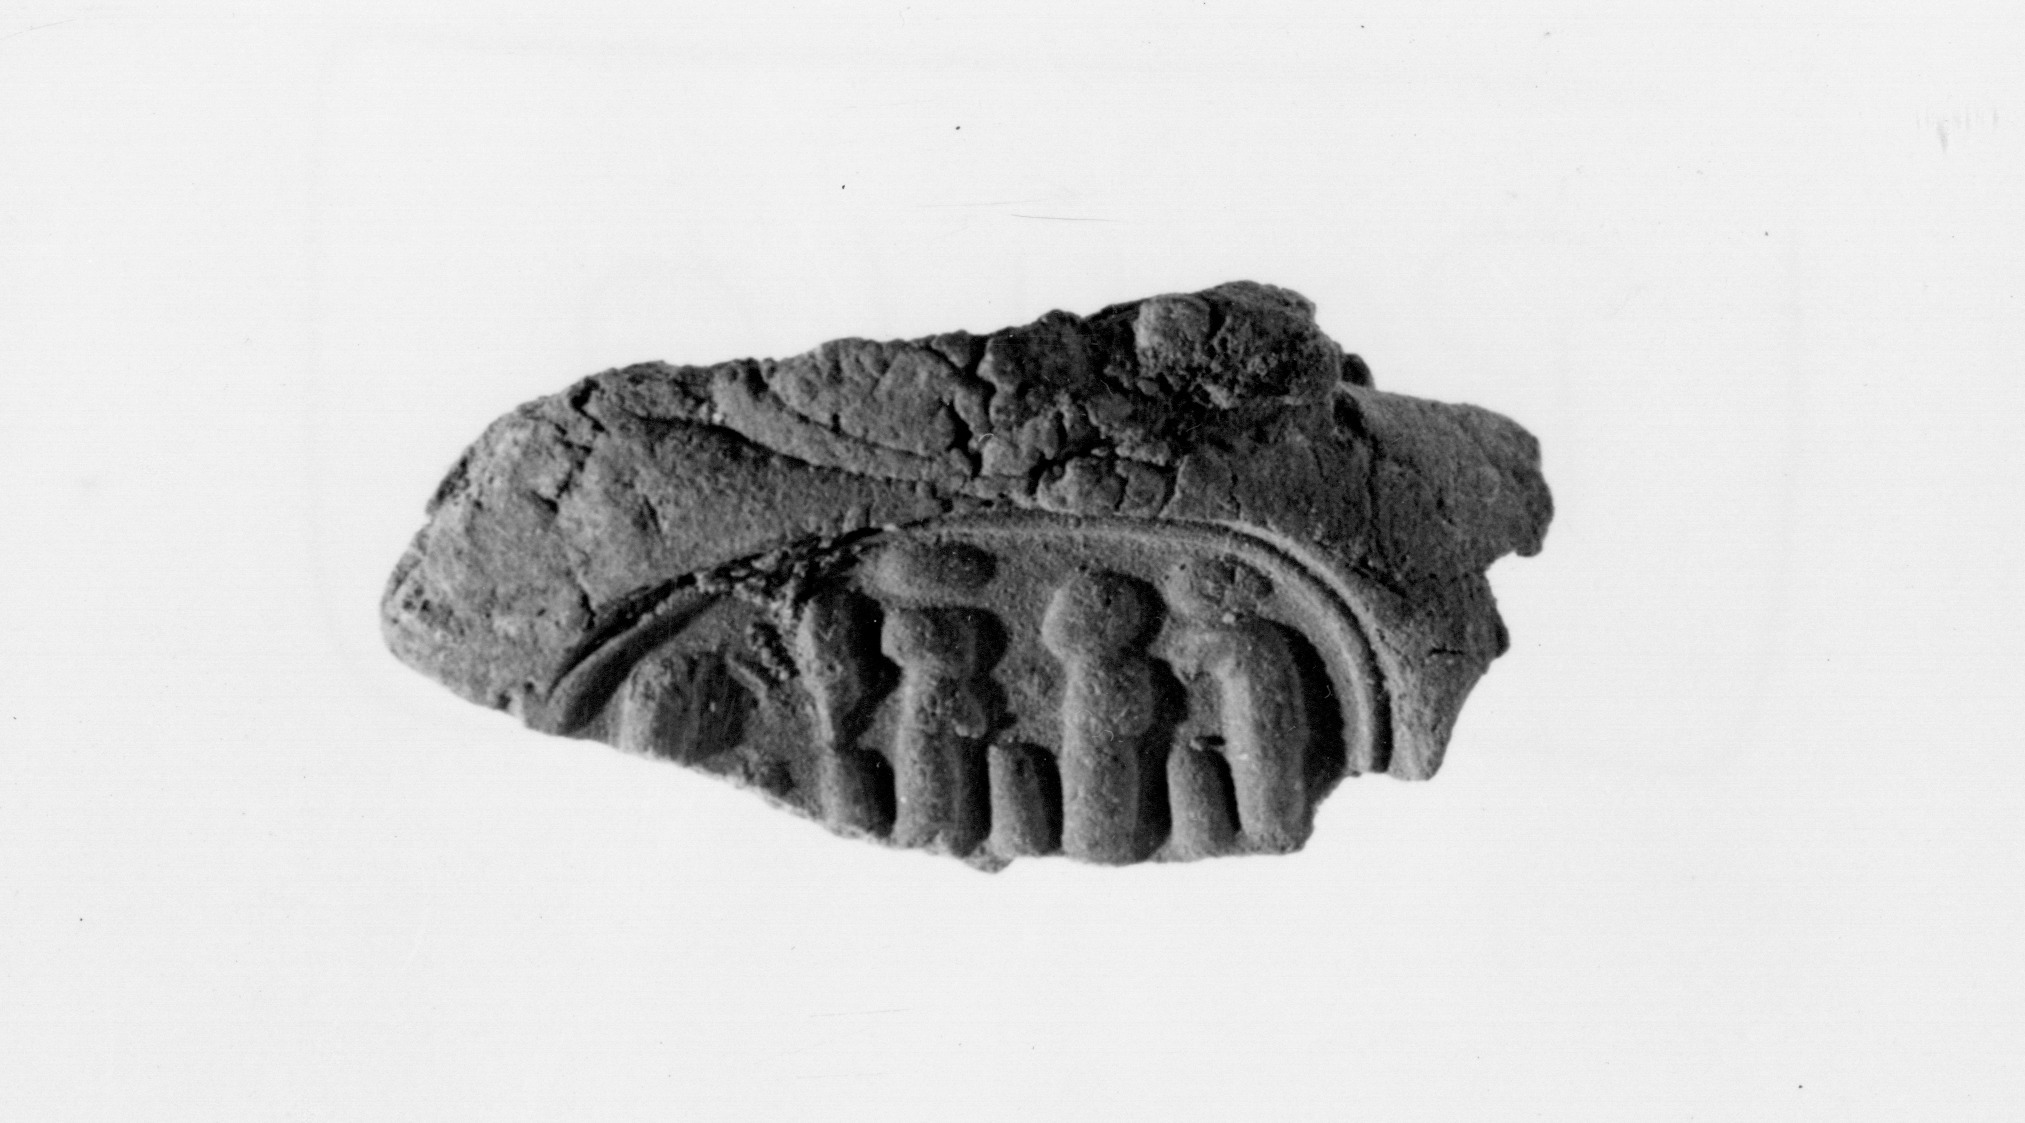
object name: sealing, nebmaatre, amenhotep iii, thoth, ptah, re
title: Document Sealing With the Throne Name of Amenhotep III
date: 1390-1352 BCE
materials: mud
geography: egypt